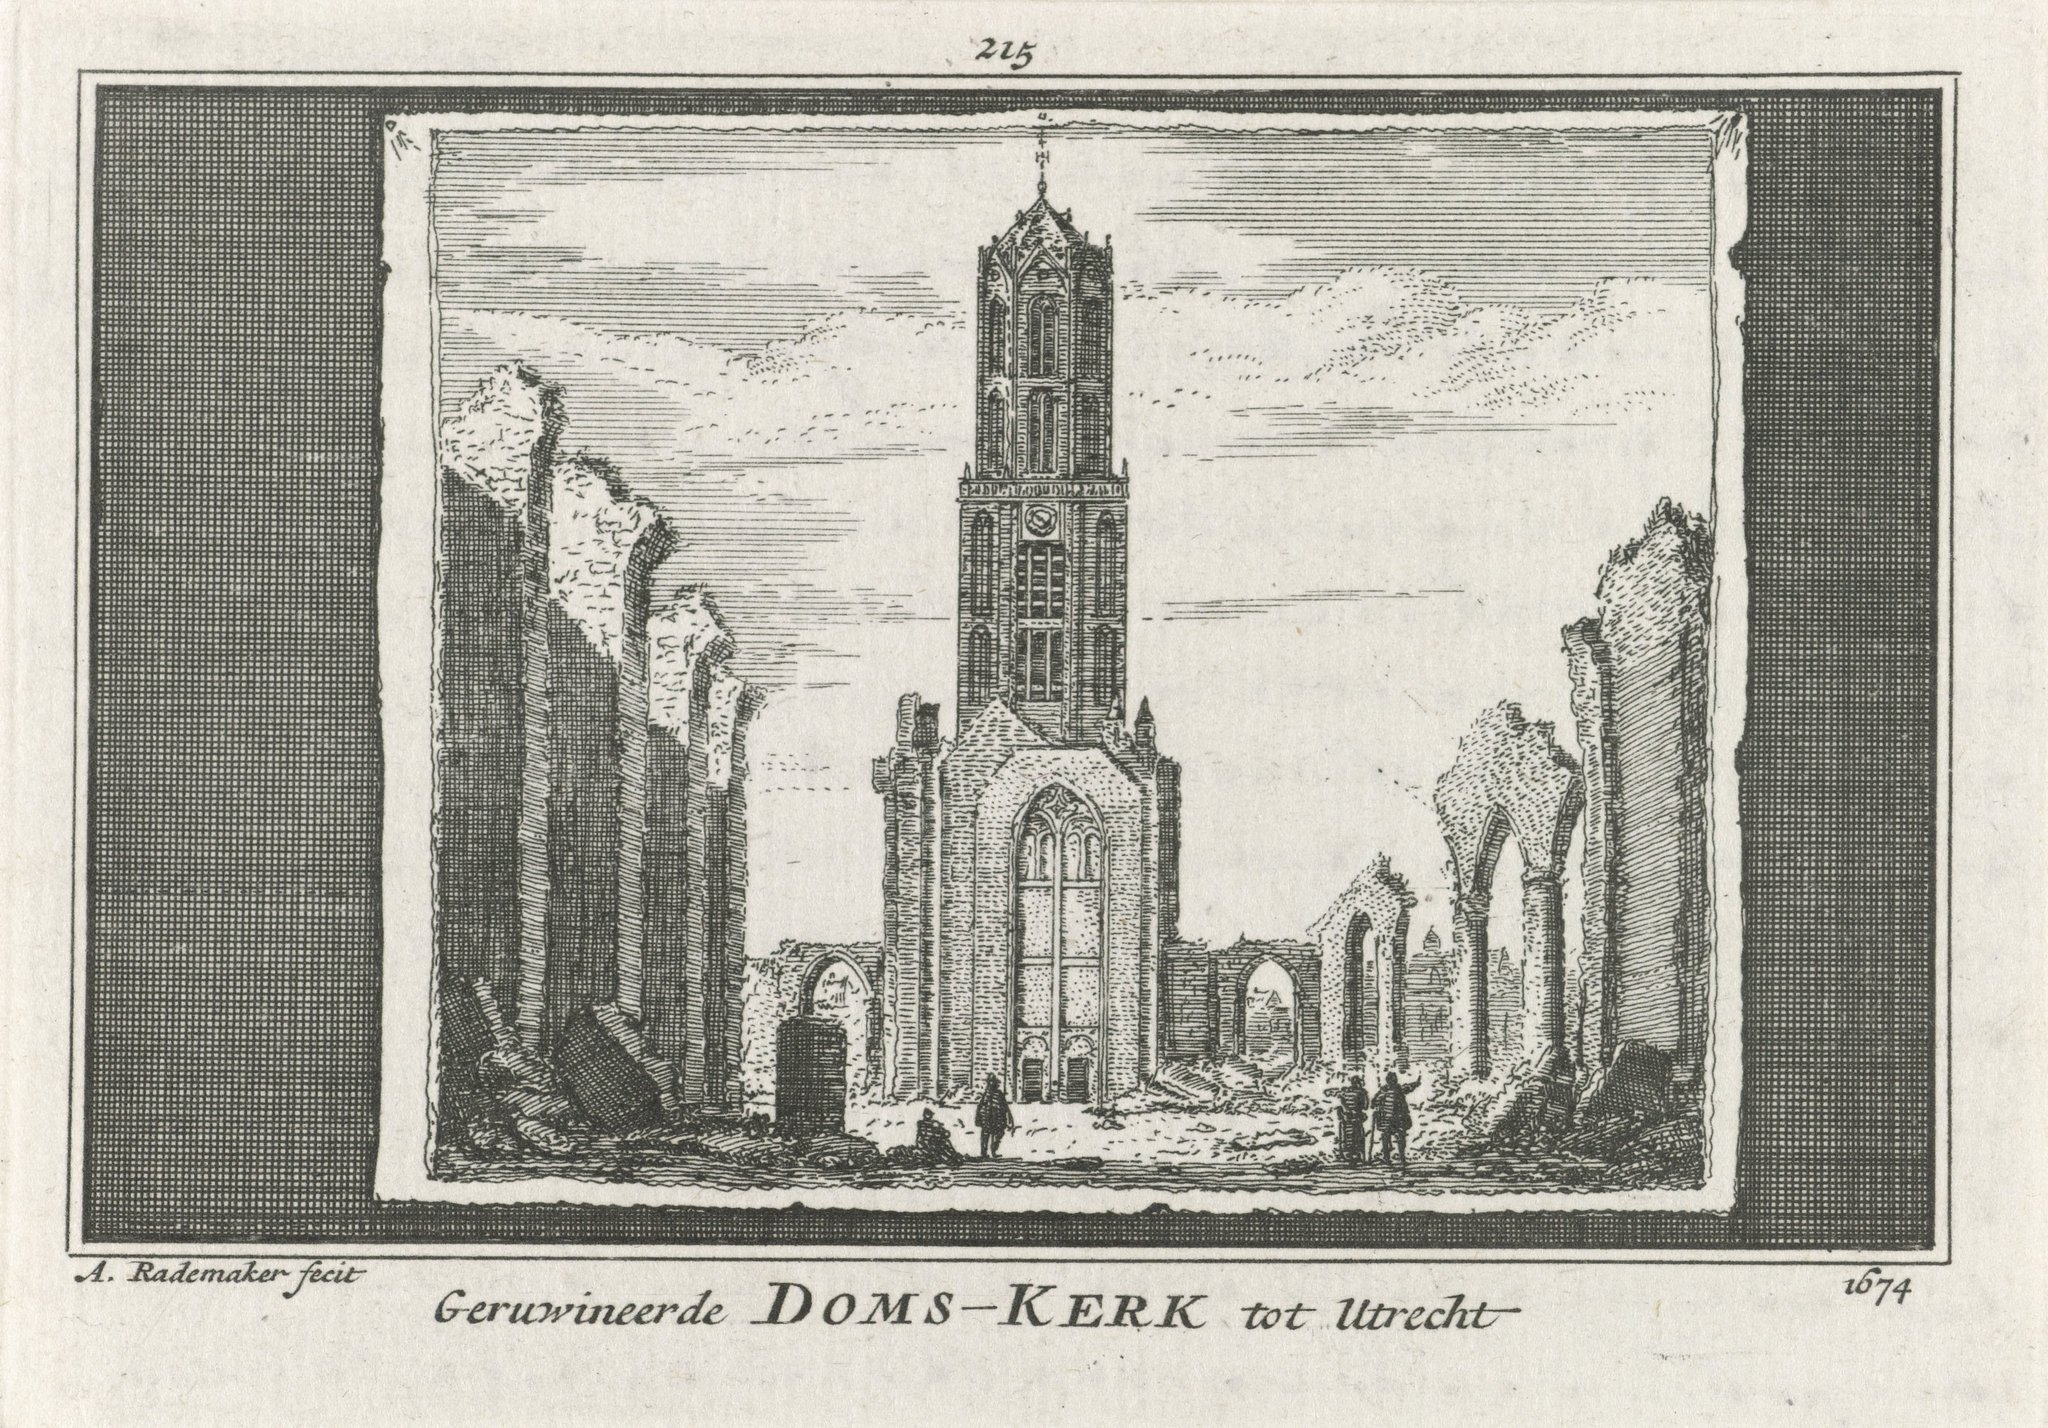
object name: print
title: De Dom te Utrecht na de storm van 1674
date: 1727-1733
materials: paper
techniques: engraving, etching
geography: amsterdam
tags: parts of church exterior and annexes: dome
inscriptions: collector's mark: Lugt 2228, inscription: ‘Anno 1674 [...]’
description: Illustratie uit: Abraham Rademaker, Matthaeus Brouërius van Niedek, Isaac Le Long, Kabinet van Nederlandsche en Kleefsche outheden en (...) voorname stads- en landgebouwen, Willem Barents en Antoni Schoonenburg: Amsterdam, 1727-1733, ill. nr. 215.